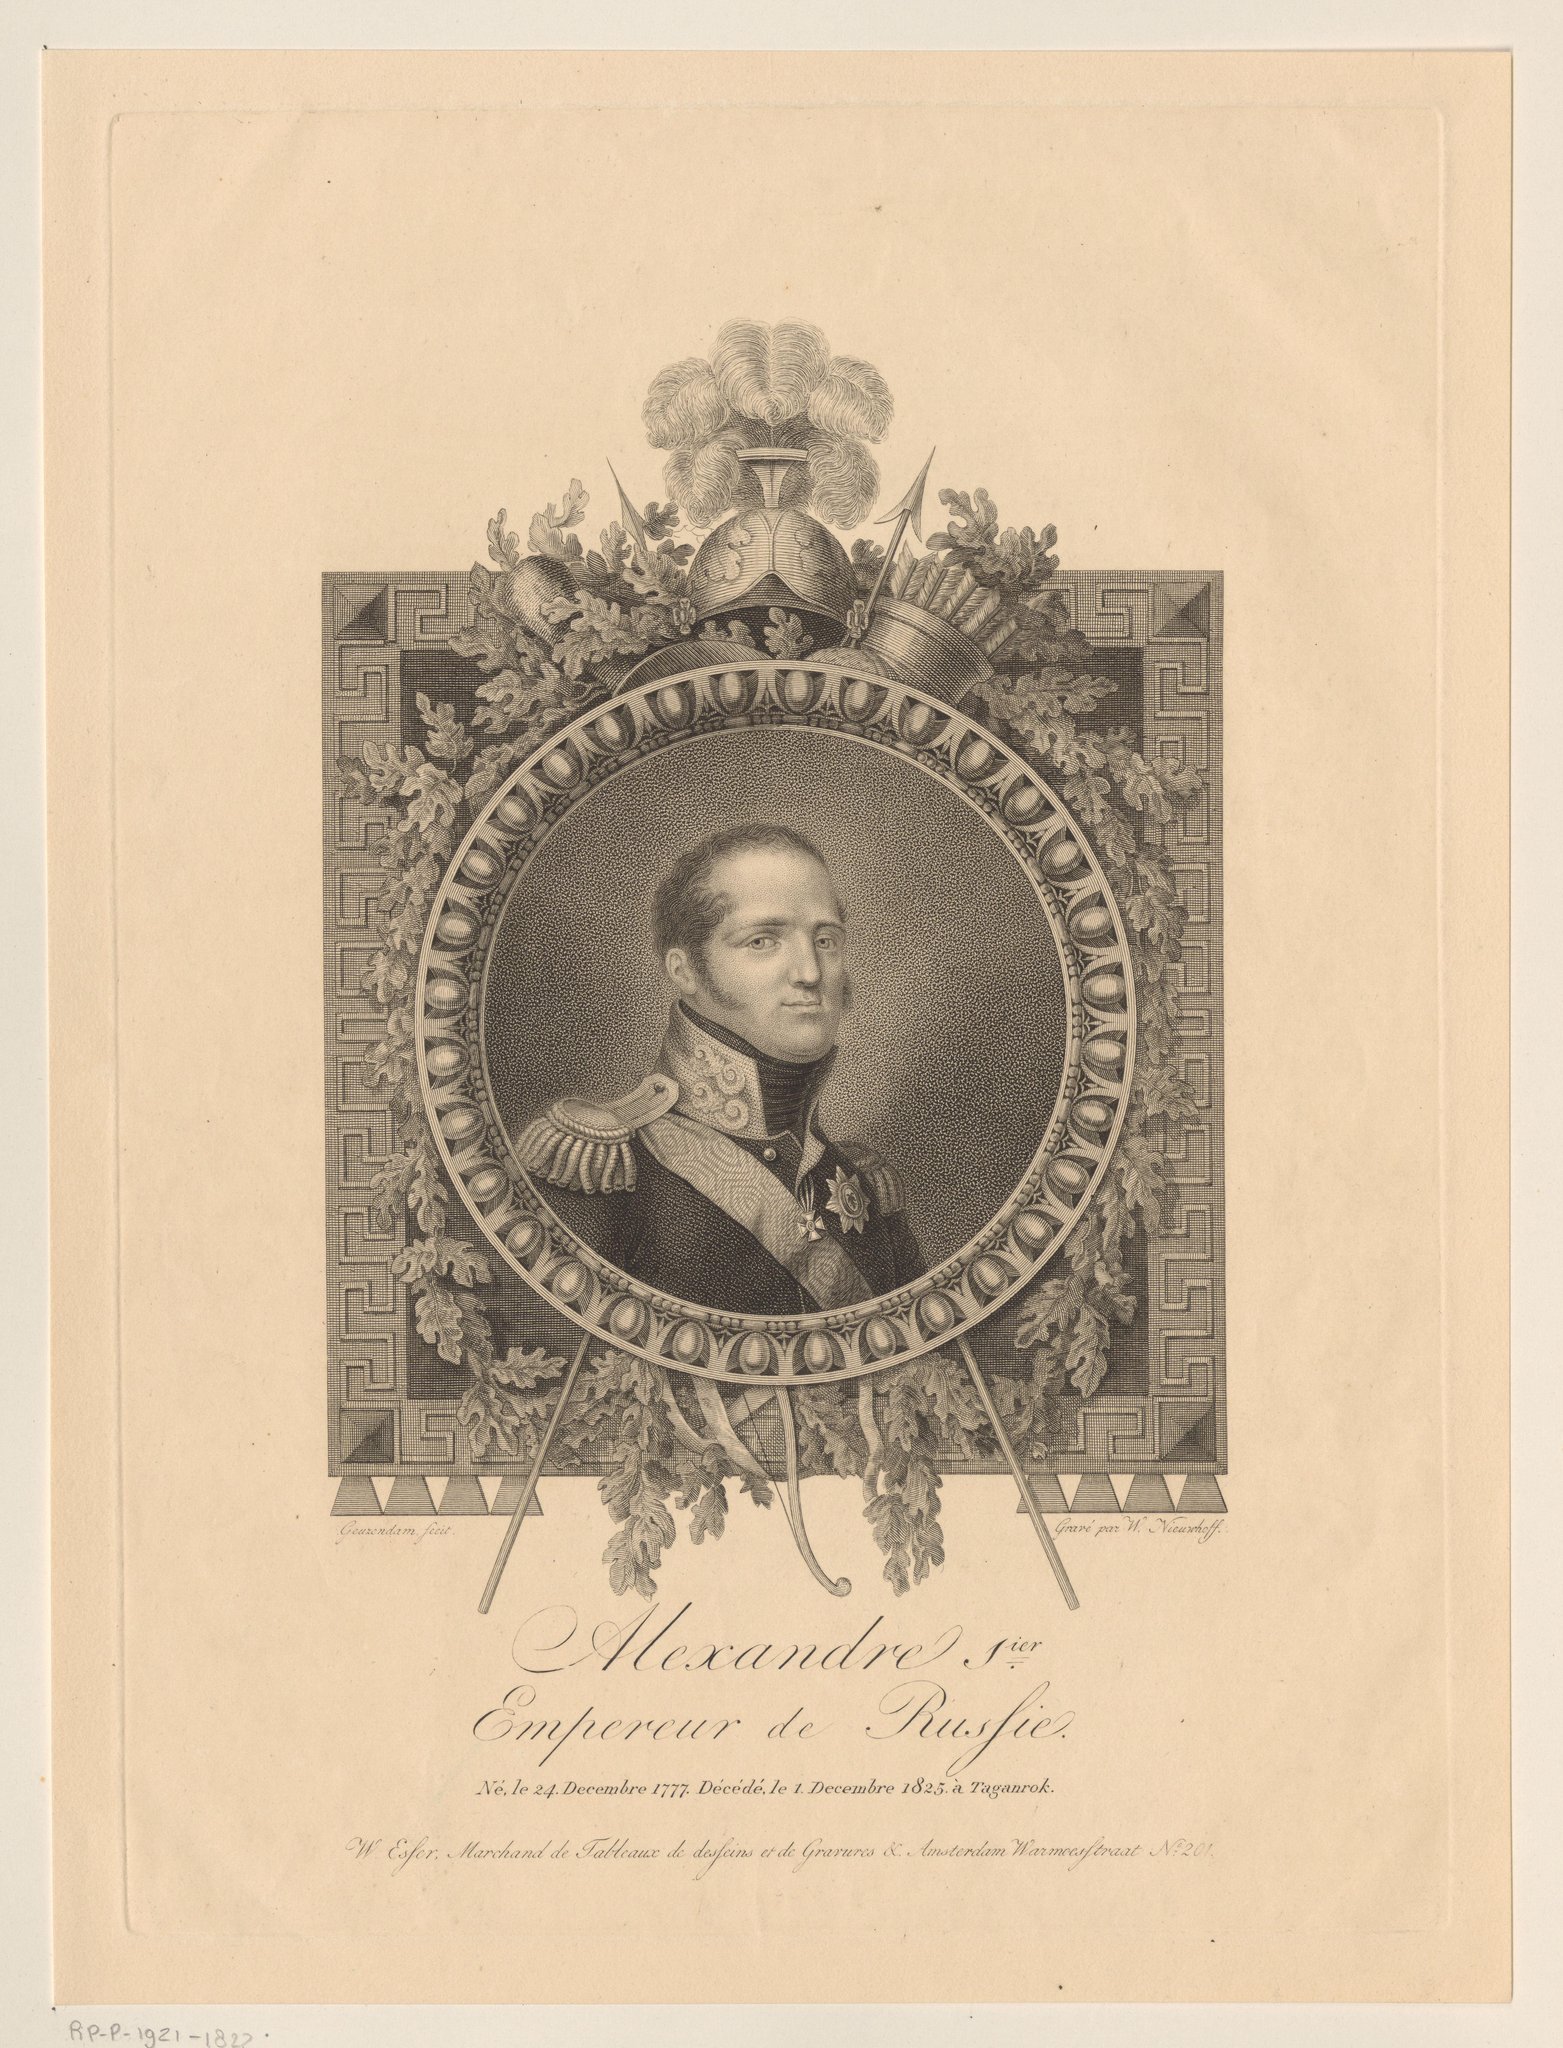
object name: print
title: Portret van Alexander I, tsaar van Rusland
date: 1825-1837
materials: paper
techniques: engraving, etching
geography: amsterdam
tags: alexander i (tsaar van rusland), helmet, archer's weapons: bow and arrow, historical persons, emperor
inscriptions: collector's mark: Lugt 2233